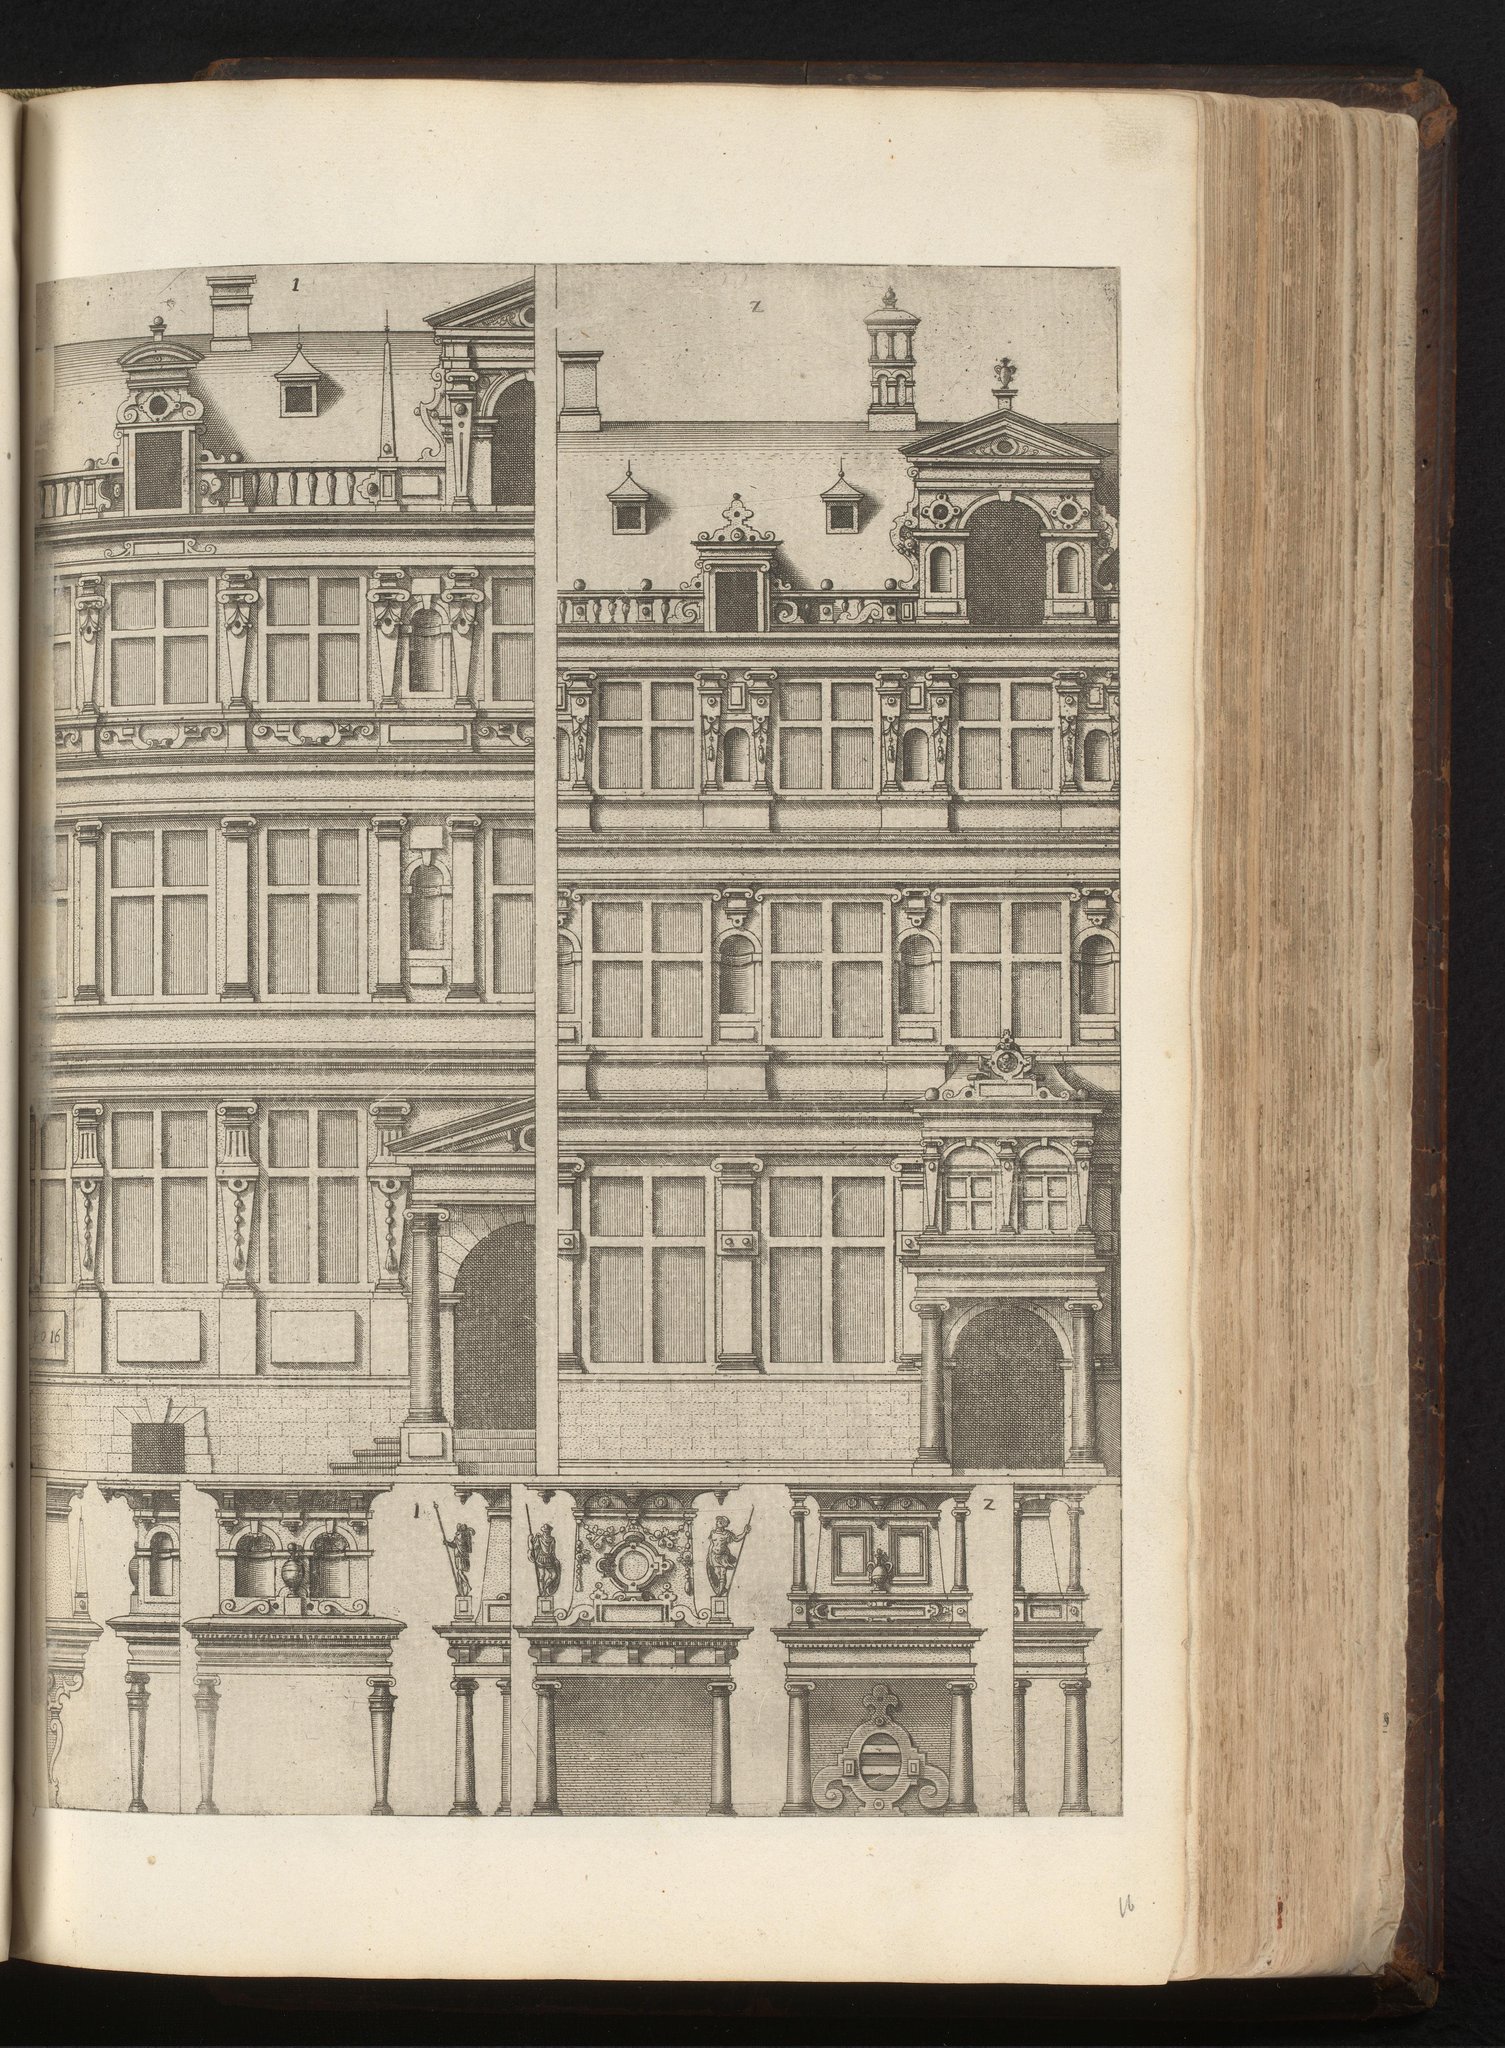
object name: album leaf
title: Gevels en haarden in de Ionische orde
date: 1581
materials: paper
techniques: engraving, etching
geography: antwerp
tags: open hearth, fire-place, ionic order ~ architecture, civic architecture; edifices; dwellings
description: Prent uit: Vredeman de Vries, Hans. Architectura oder Bauung der Antiquen auss dem Vitruvius, waellches sein funff Collummen orden, (...). Antwerpen: Gerard de Jode en Gerard Smits, 1581. Prent eerder verschenen in de 1577-editie.